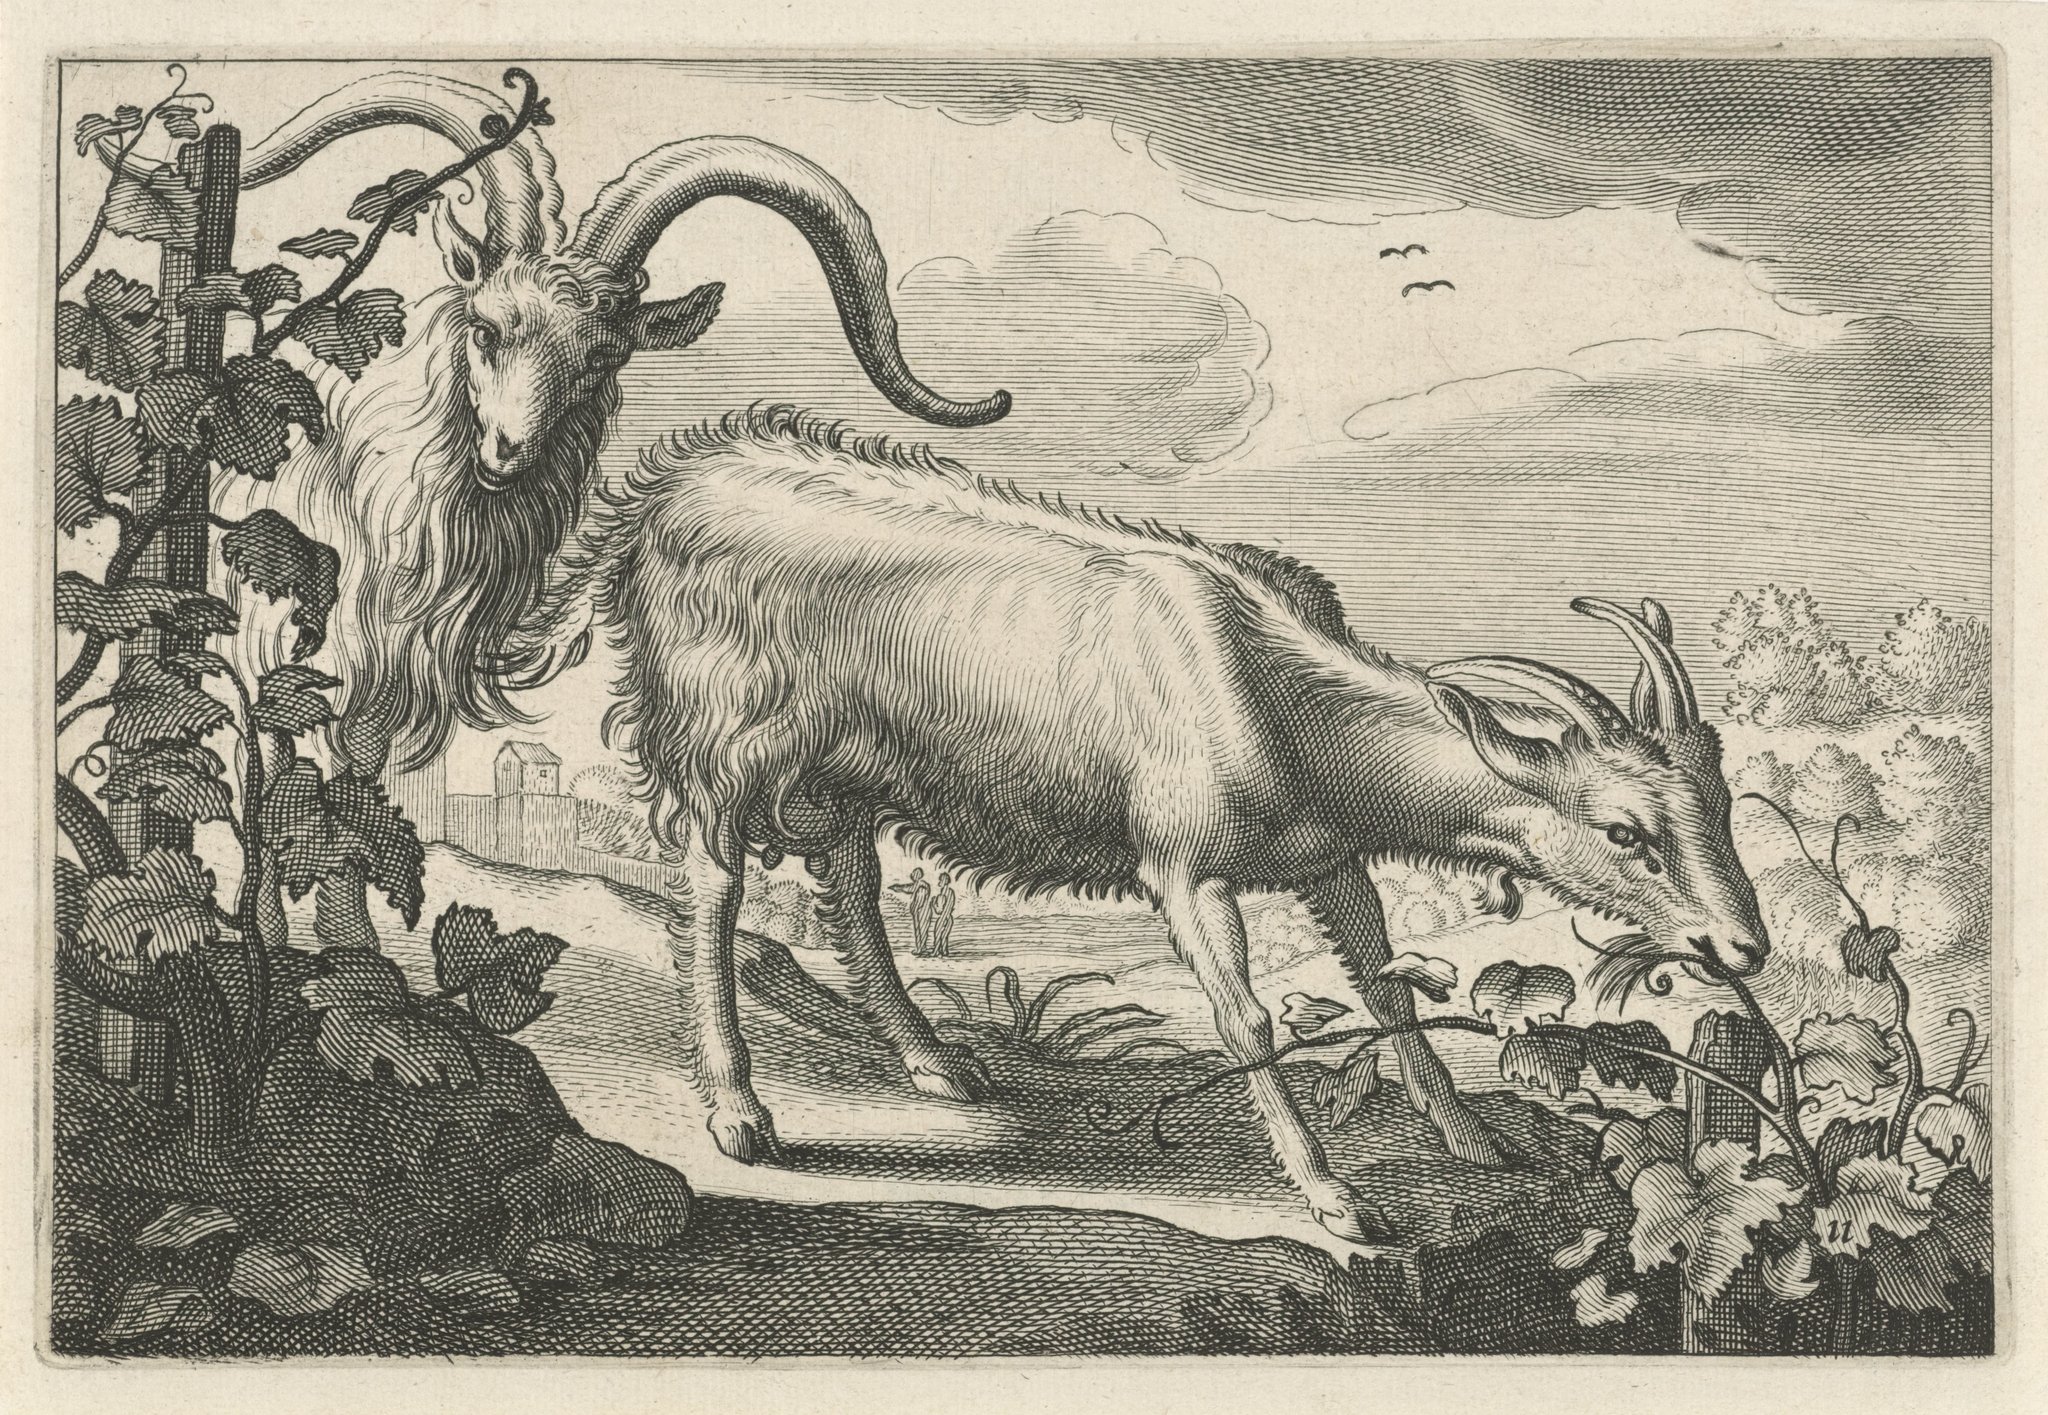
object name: print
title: Diversa Animalia Quadrupedia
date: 1641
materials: paper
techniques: engraving, etching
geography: northern netherlands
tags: vineyard, goat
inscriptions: collector's mark: Lugt 2228